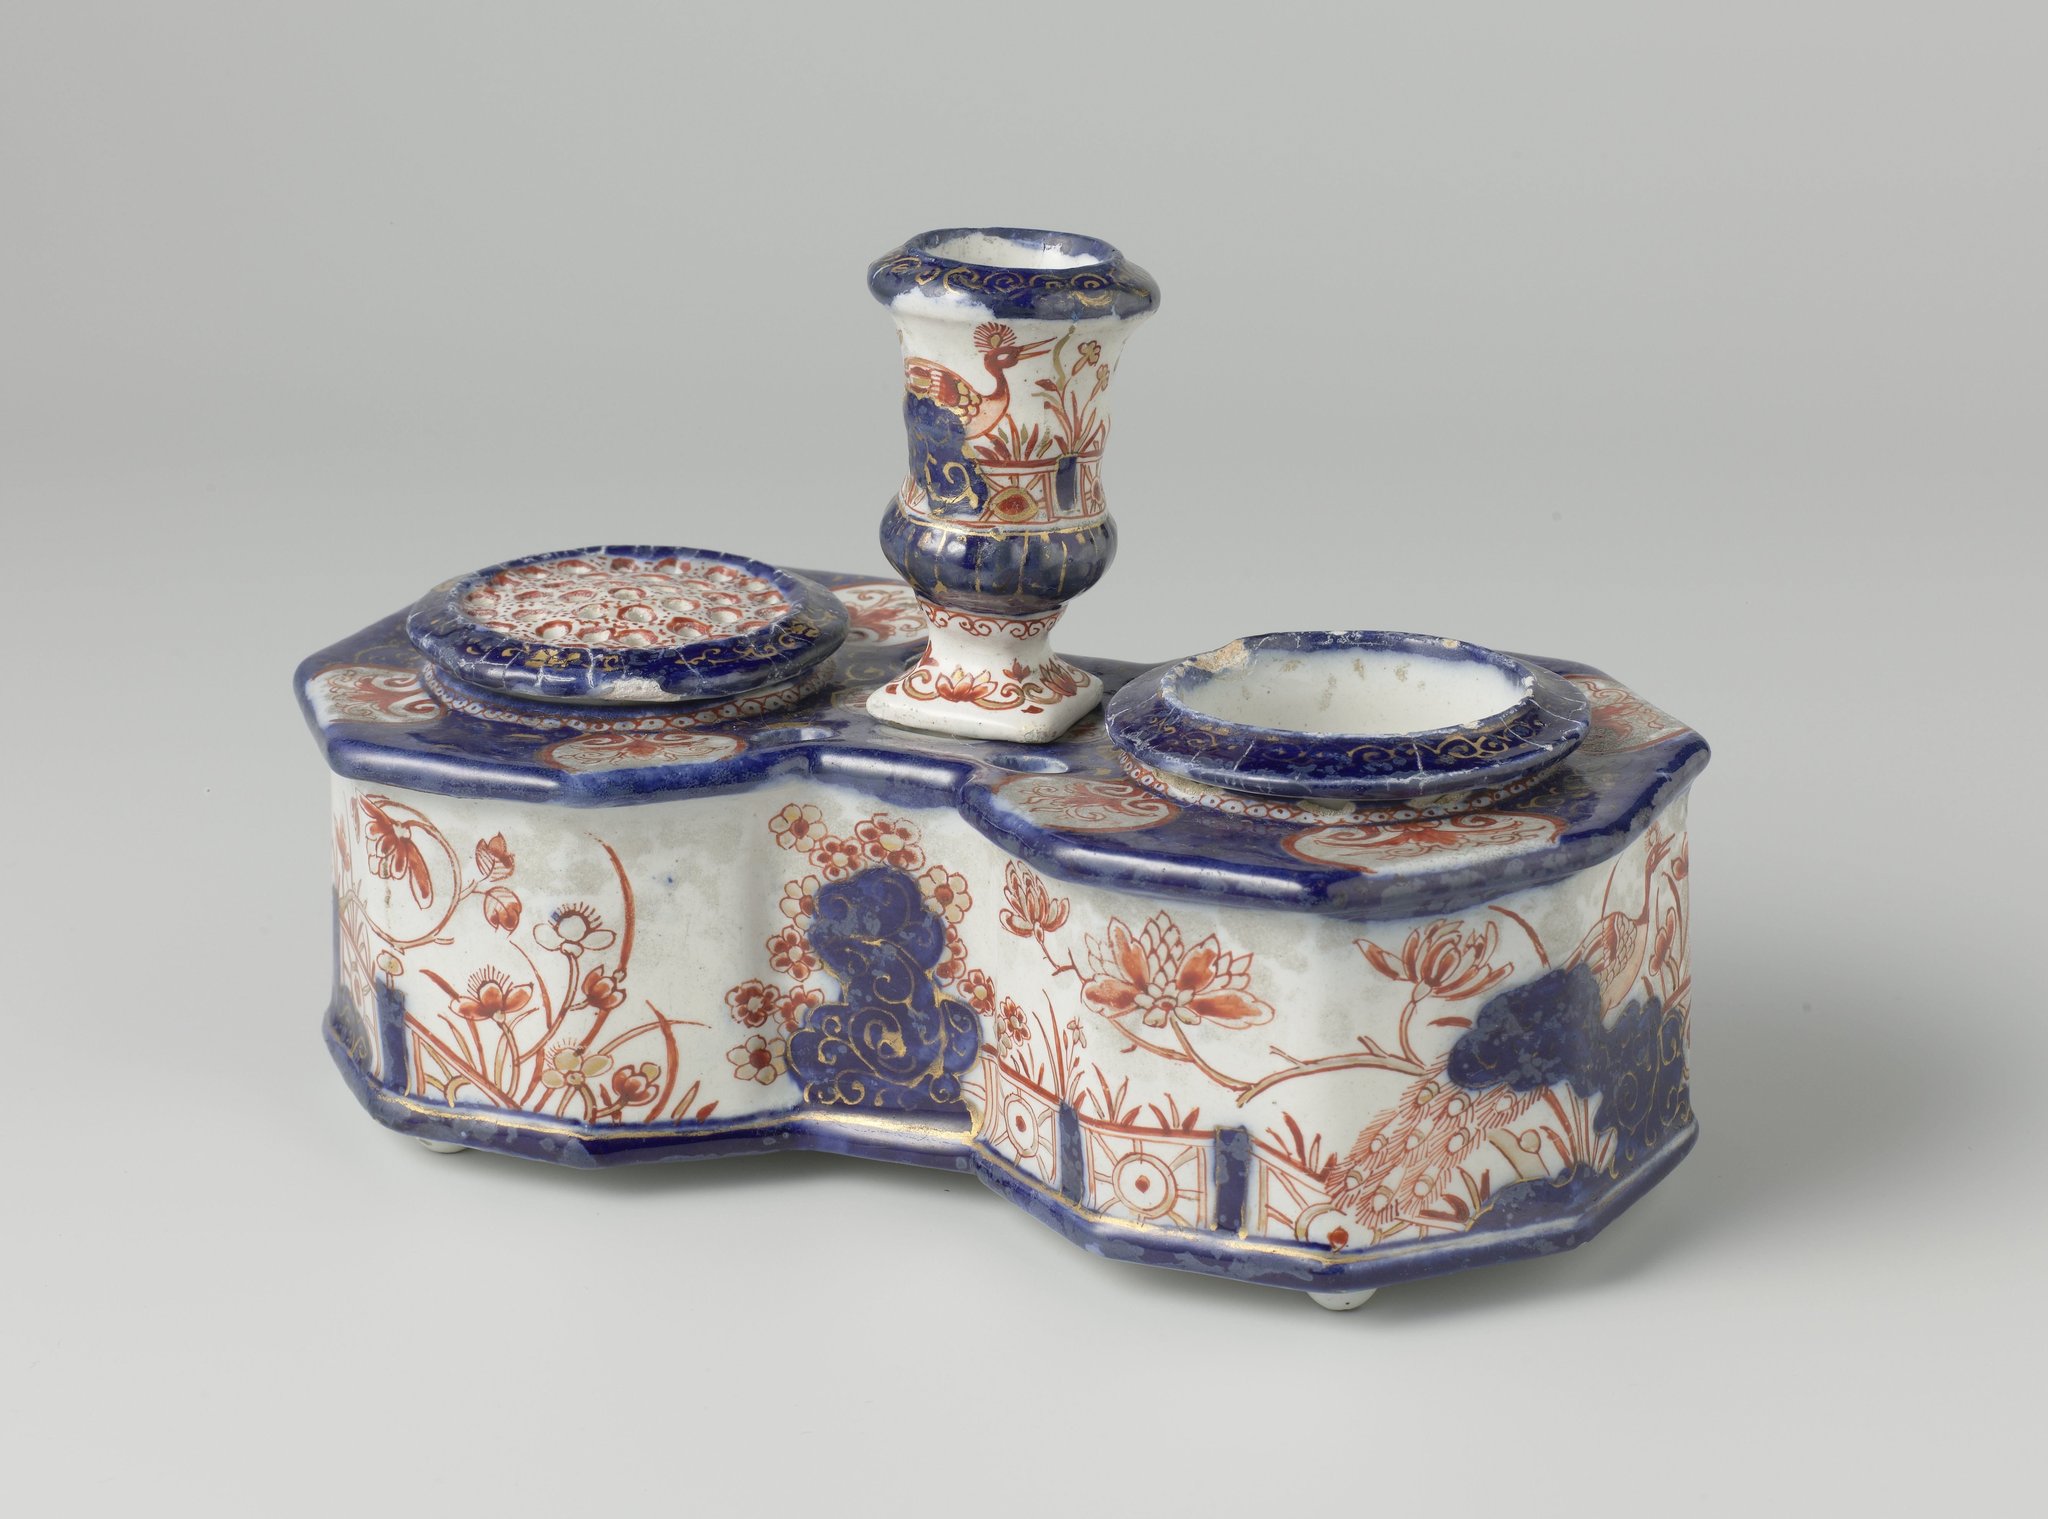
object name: inkstand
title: Inktstel van veelkleurig beschilderde faïence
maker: Anonymous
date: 1705-1725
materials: earthenware, glaze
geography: delft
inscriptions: collector's mark: ‘Collection J.F. Loudon’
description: Inktkoker van faïence. Veelkleurig beschilderd.